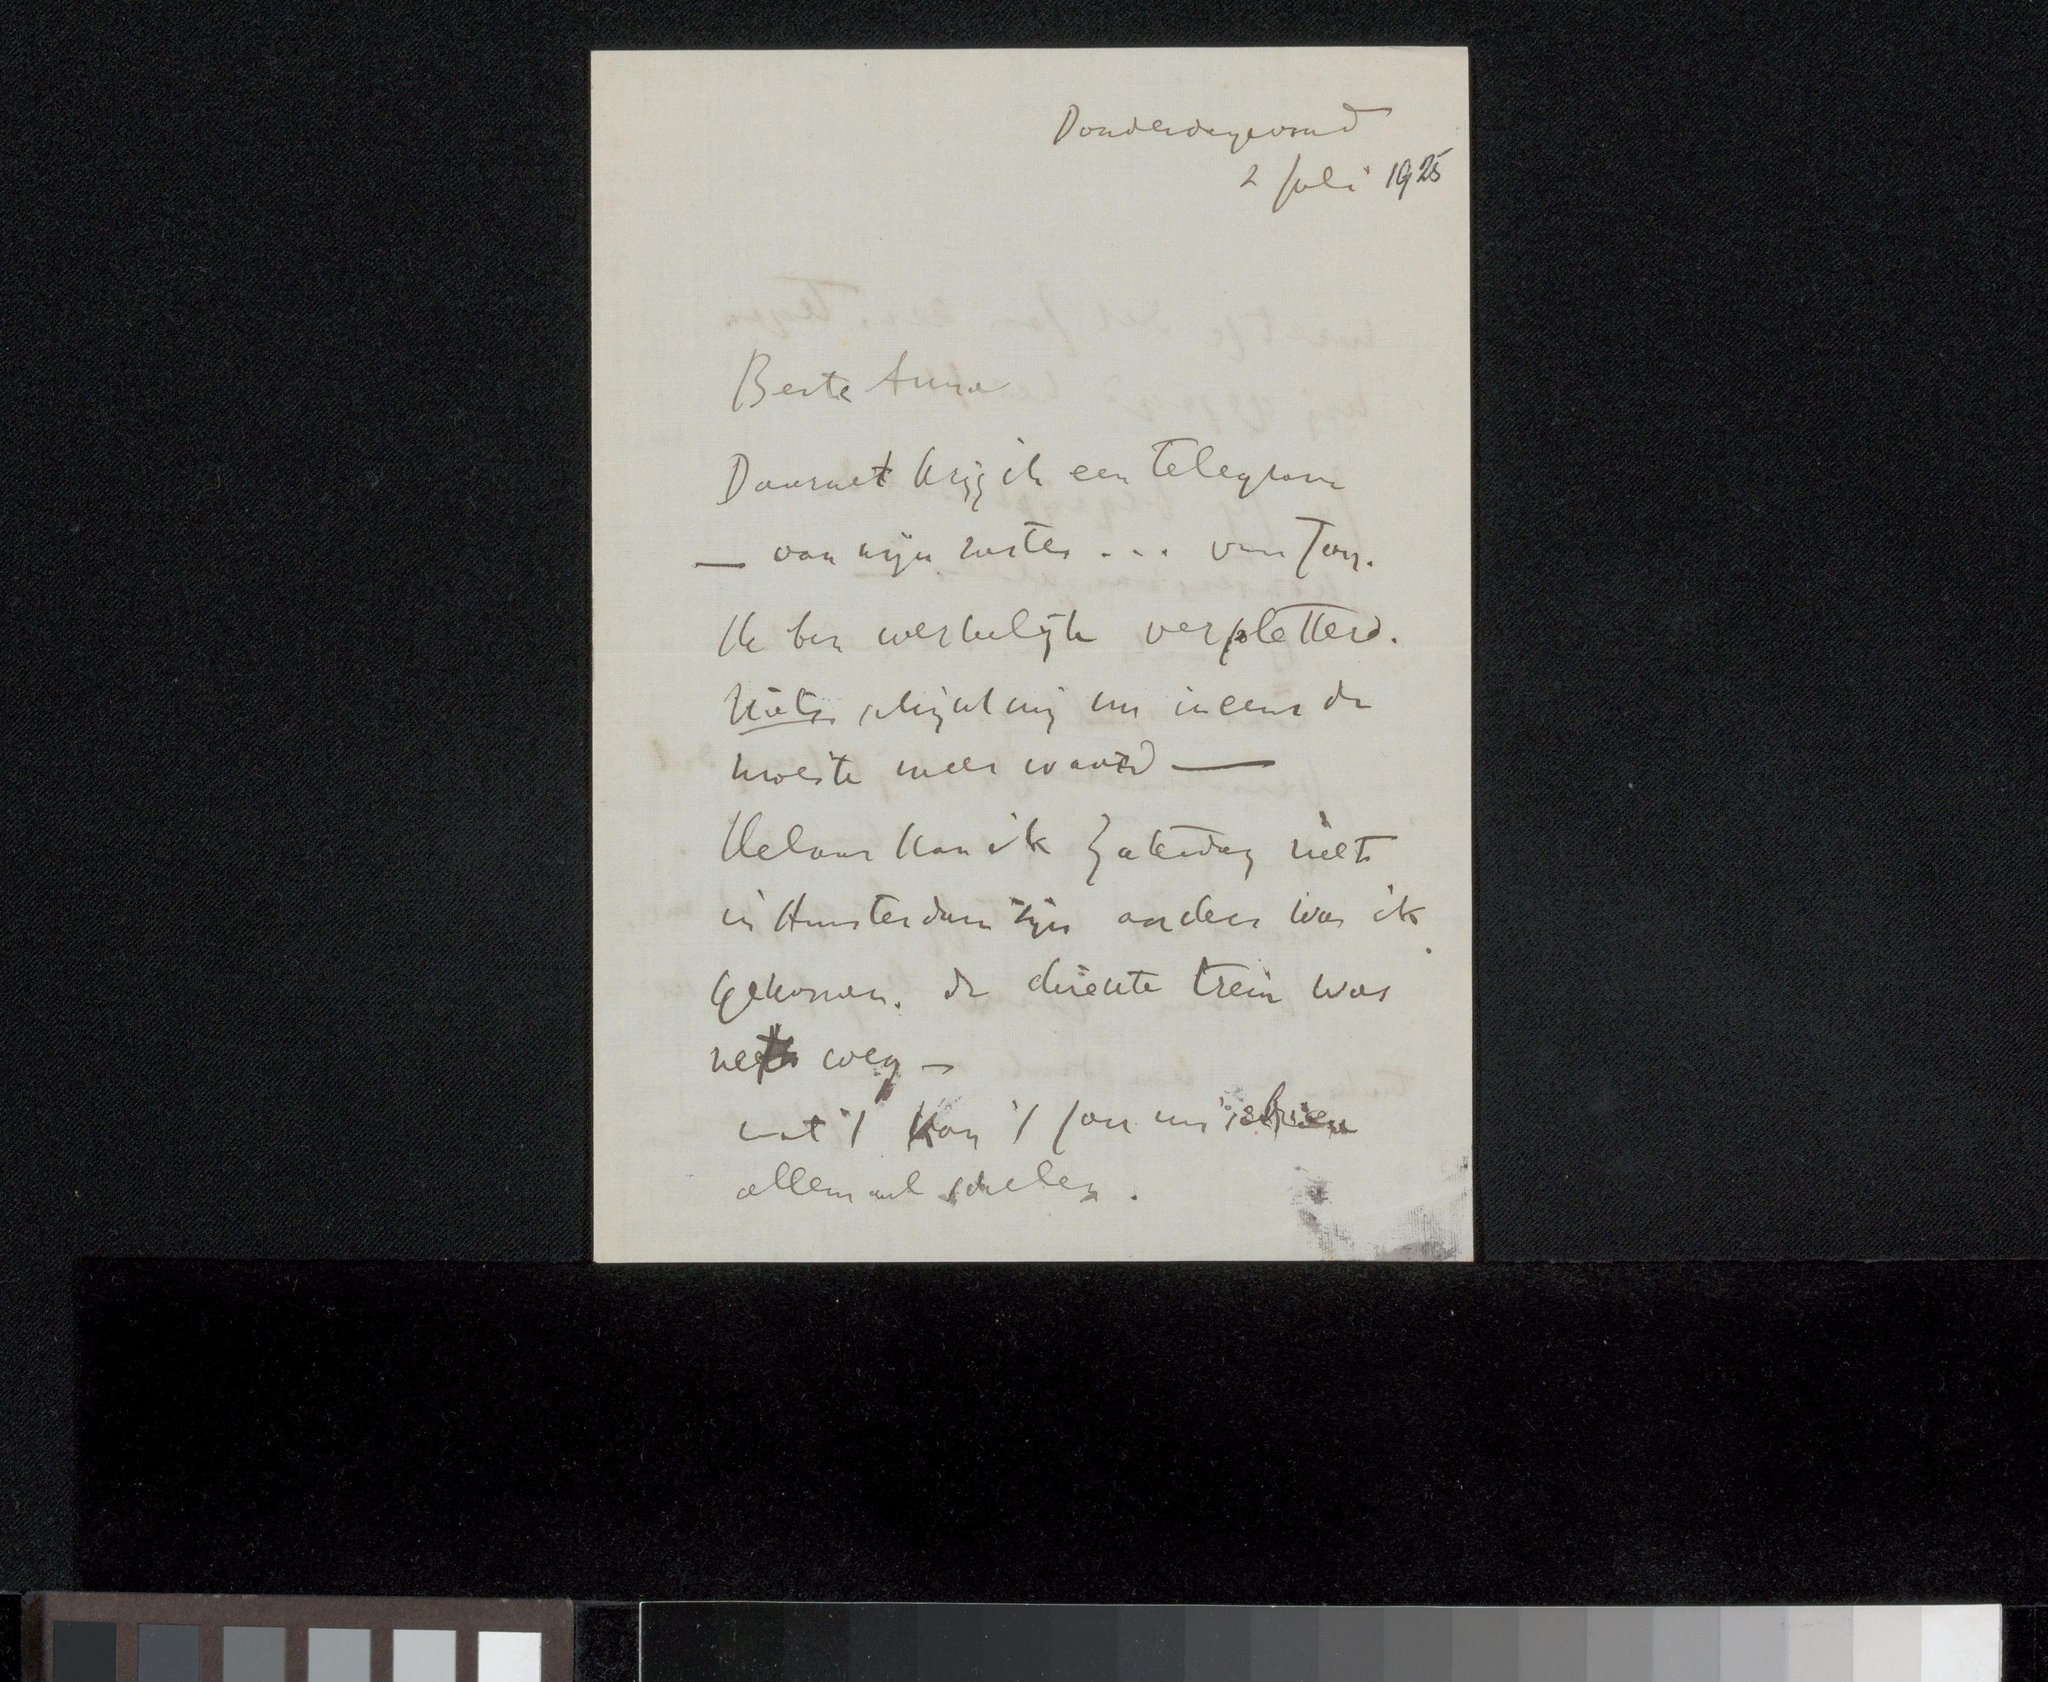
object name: letter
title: Brief aan Anna Dorothea Dirks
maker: isaac israels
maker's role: draughtsman, painter, print maker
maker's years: 1865-1934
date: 1875-1929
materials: cardboard, ink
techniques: photograph, pen, writing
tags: dordrecht, designer, jan veth, artist, anna dorothea dirks, passions, emotions, affections, family life, amsterdam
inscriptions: collector's mark: ‘RPK’, watermark